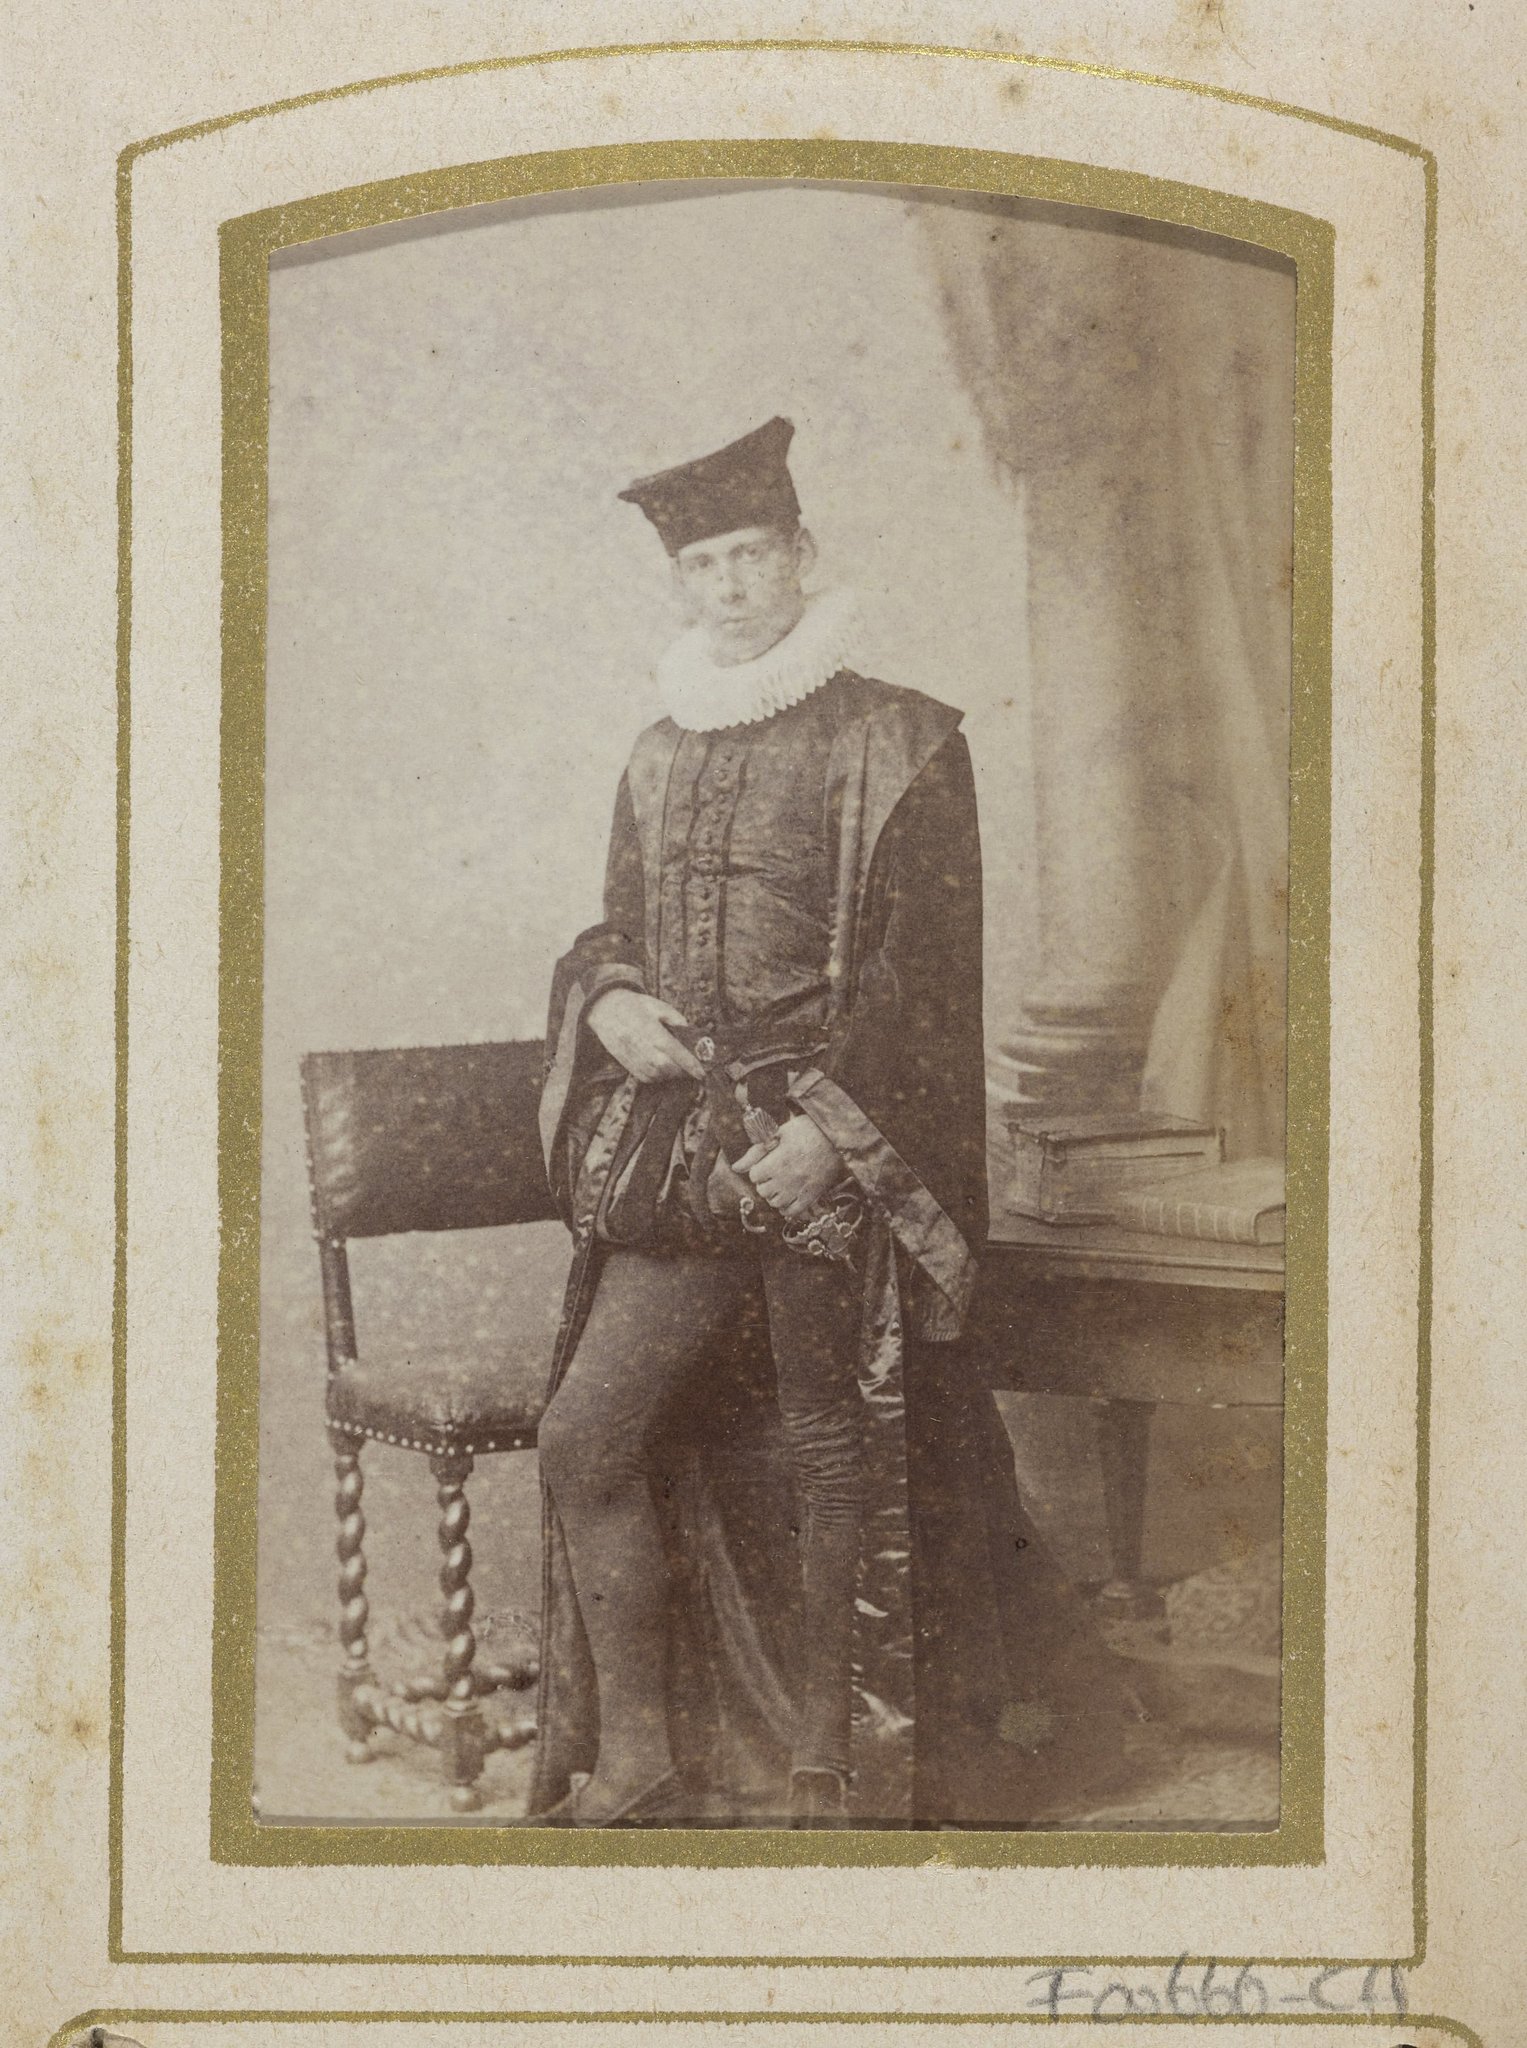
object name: album leaf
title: Portret van een jonge man in kostuum bij een stoel en een tafel met boeken, aangeduid als J.W. Huijsinga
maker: jan goedeljee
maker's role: fotograaf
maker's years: 1824-1905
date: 1860-1905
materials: cardboard, photographic support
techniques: albumen print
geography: leiden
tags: historical persons, table, historical costume, chair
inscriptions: inscription: ‘J. Goedeljee/ Photograaf/ Z. K. H. PRINS ALEXANDER/ der Nederlanden/ PRINS van ORANJE/ en H. K. H./ PRINSES HENDRIK/ der Nederlanden/ Hoogewoerd 160/ nabij de Plantage.’, name: ‘J. W. Huysinga. 128.’